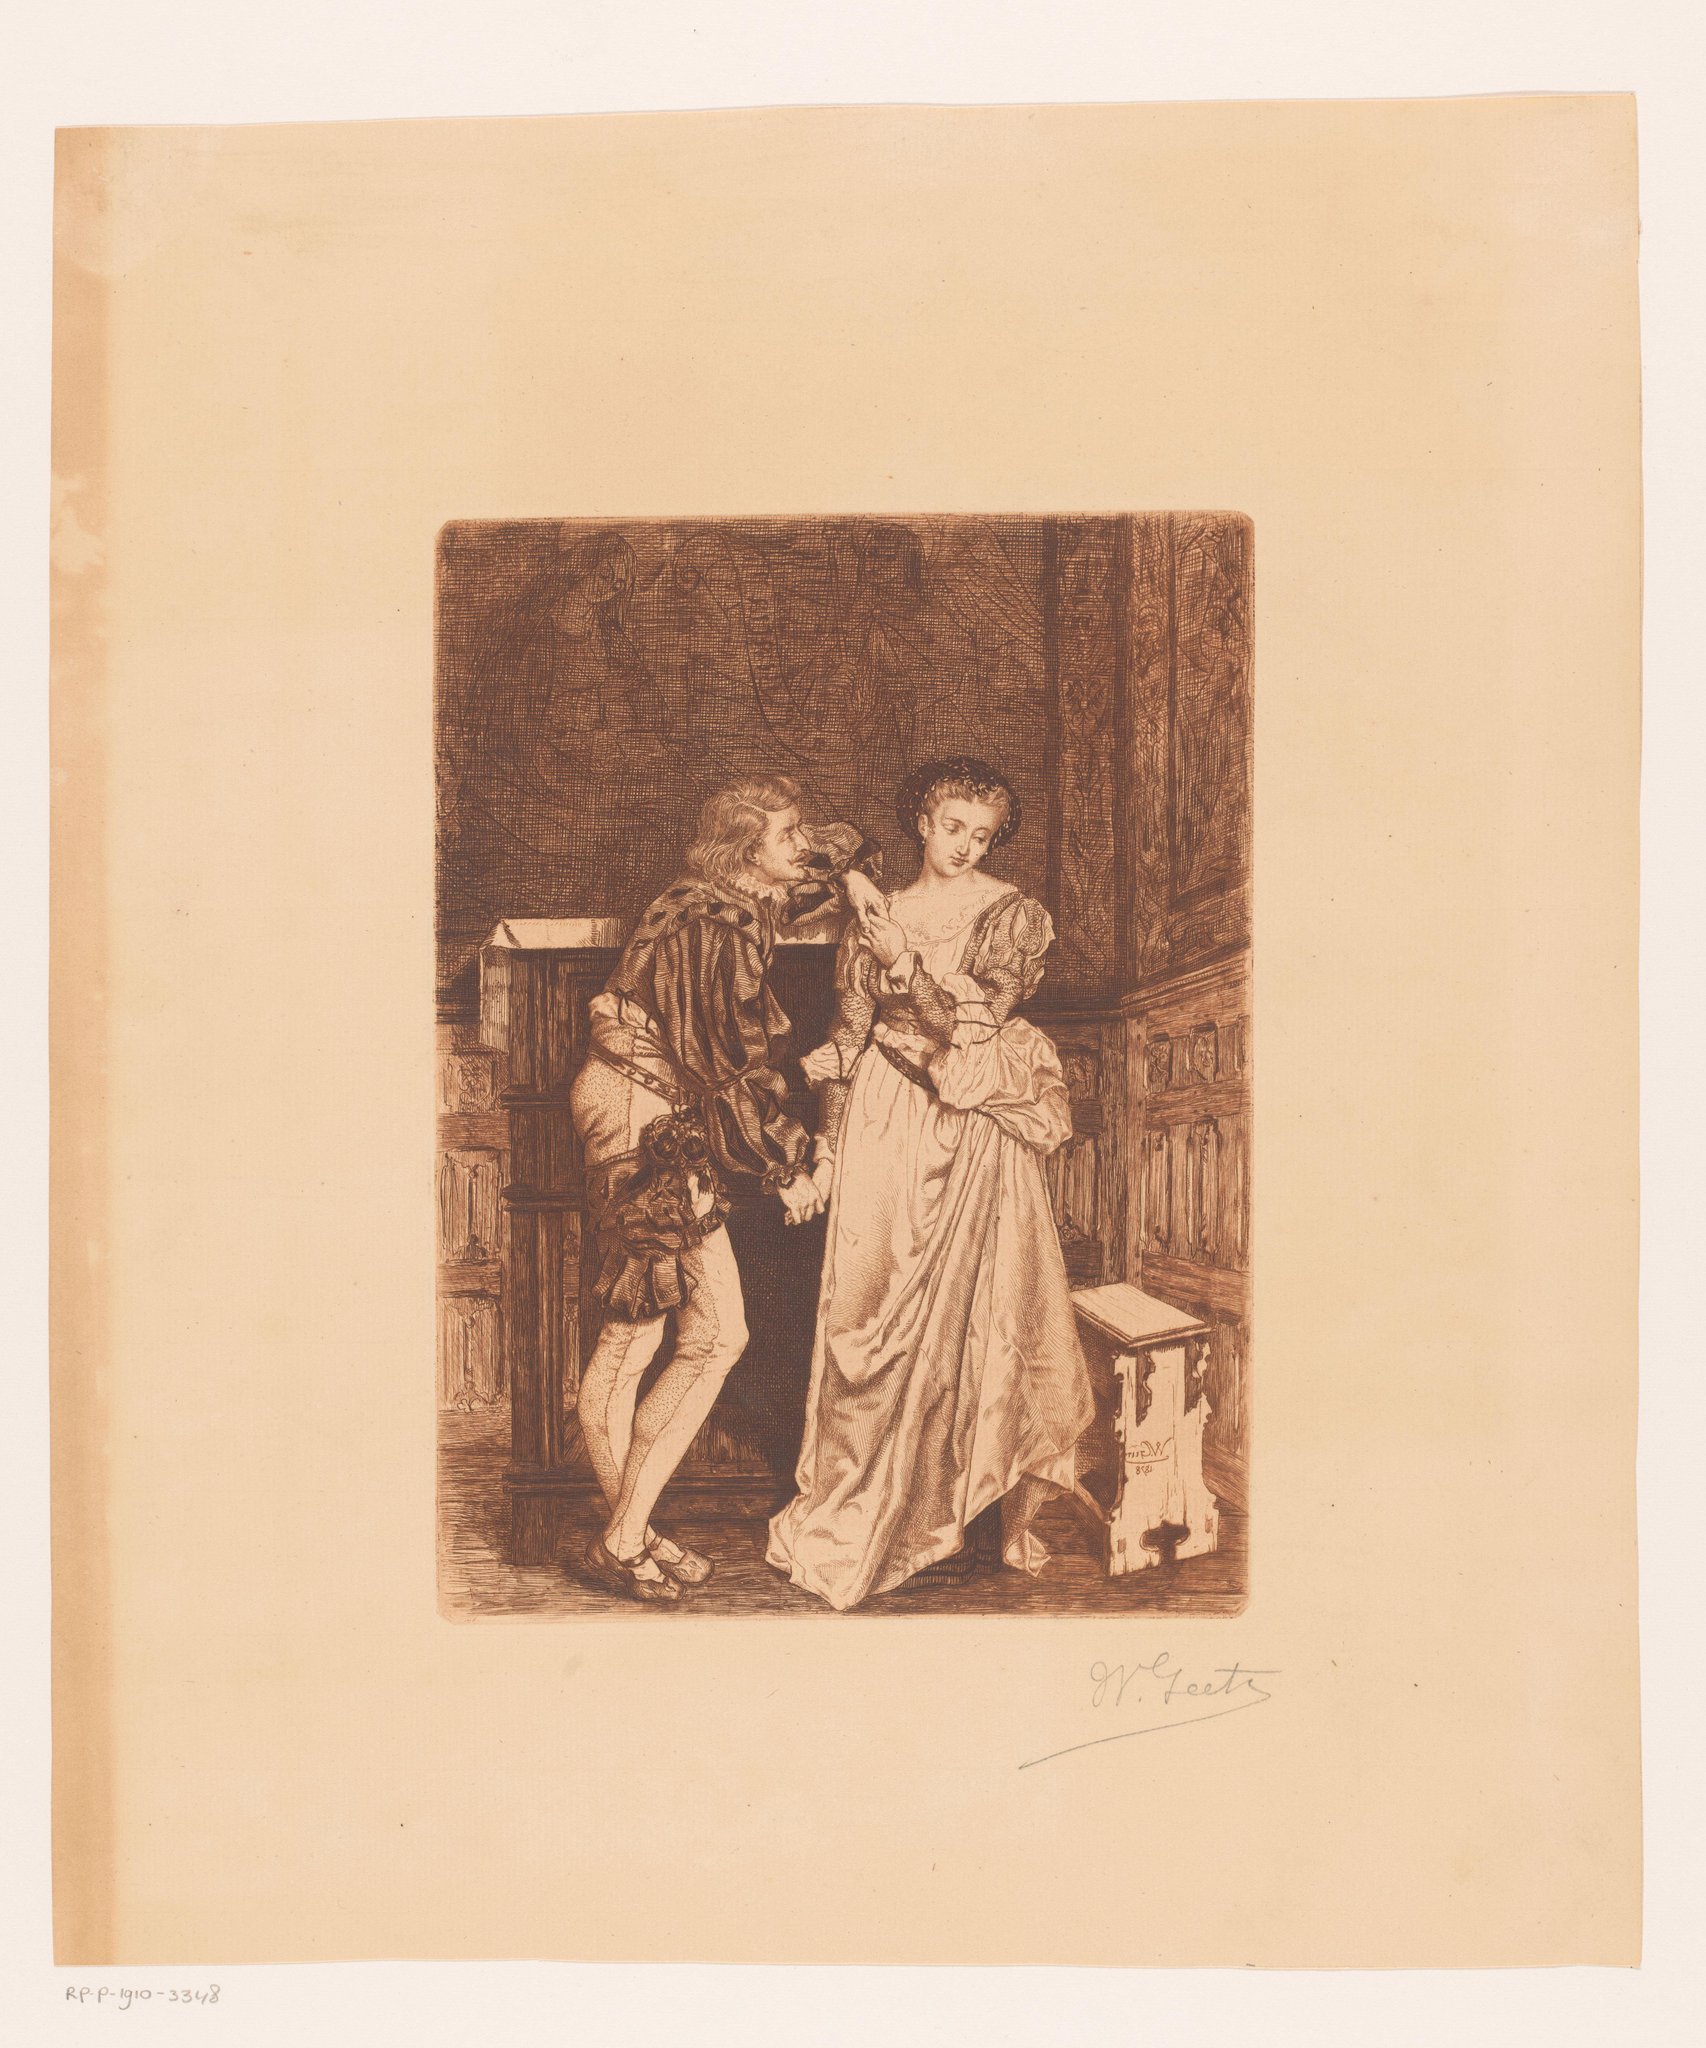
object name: print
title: Jong koppel in een interieur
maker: willem geets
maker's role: print maker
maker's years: 1838-1919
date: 1878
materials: paper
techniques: etching, intaglio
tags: courting, being refused, the proposal rejected, couple of lovers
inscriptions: collector's mark: Lugt 2228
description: Een jonge man houdt de handen van een jonge vrouw vast. De vrouw kijkt weg.